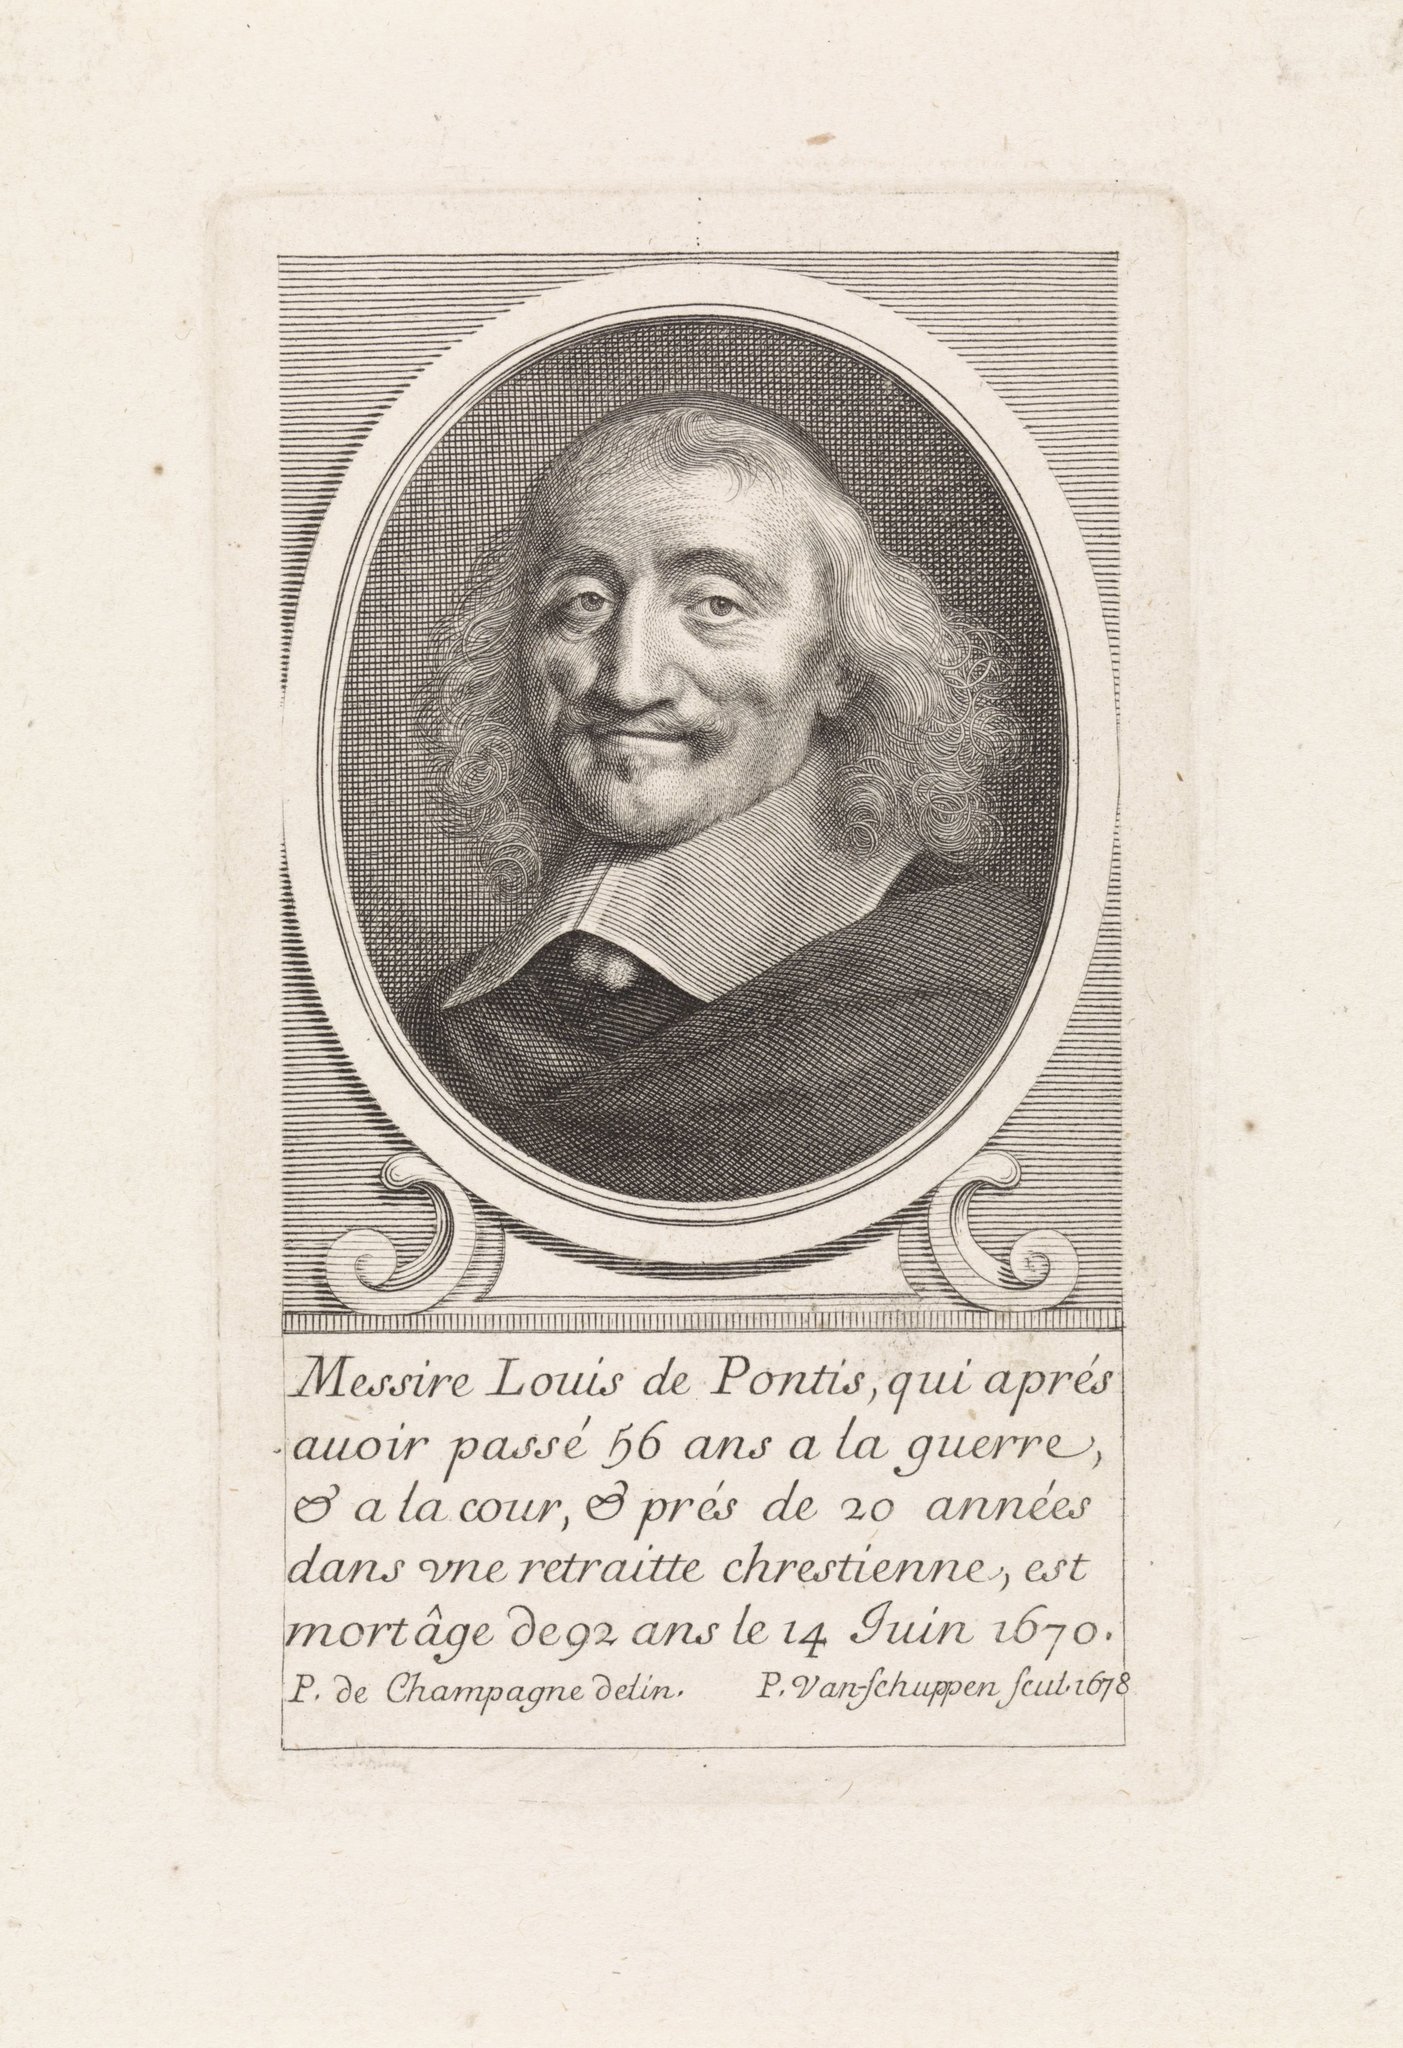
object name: print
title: Portret van Louis de Pontis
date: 1678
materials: paper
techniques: engraving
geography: paris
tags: maarschalk, louis de pontis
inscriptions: collector's mark: Lugt 2228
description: Portret van de maarschalk Louis de Pontis. Onder het portret zijn naam, sterfdatum en een korte levensbeschrijving.